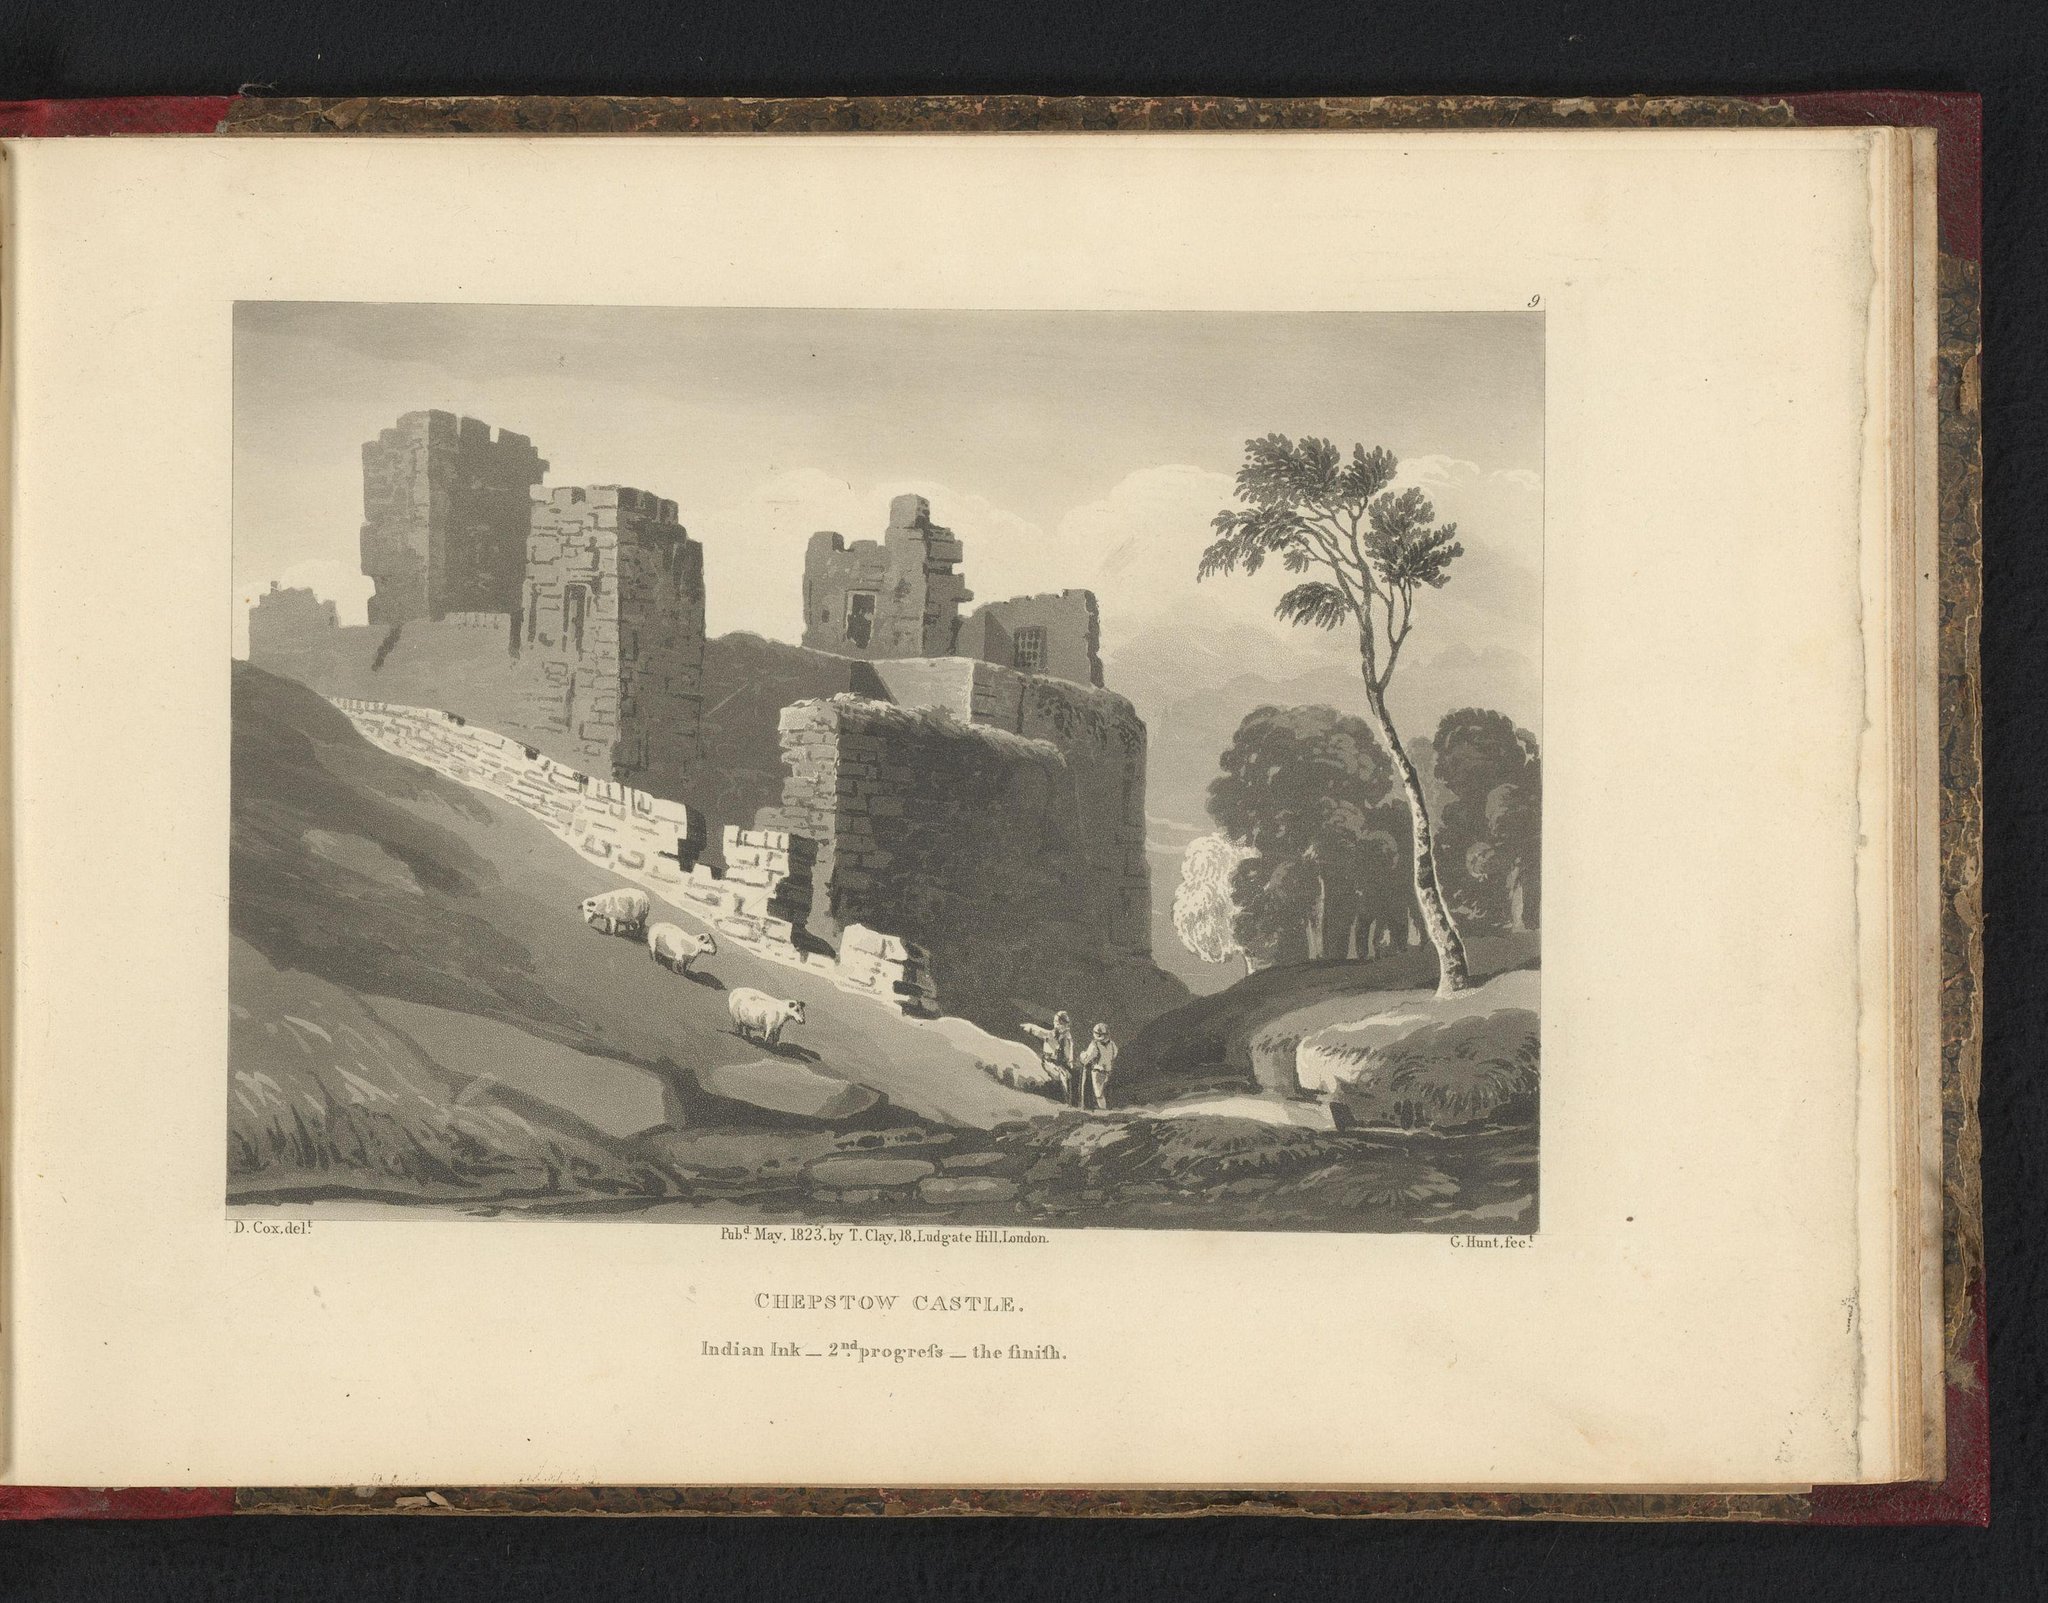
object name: print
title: Landschap met ruïne van Chepstow Castle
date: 1828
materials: paper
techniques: aquatint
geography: london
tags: painting (including book-illumination, miniature-painting), landscape with ruins (+ city(-scape) with figures, staffage)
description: Prent is gedrukt op de pagina tegenover pagina 18.